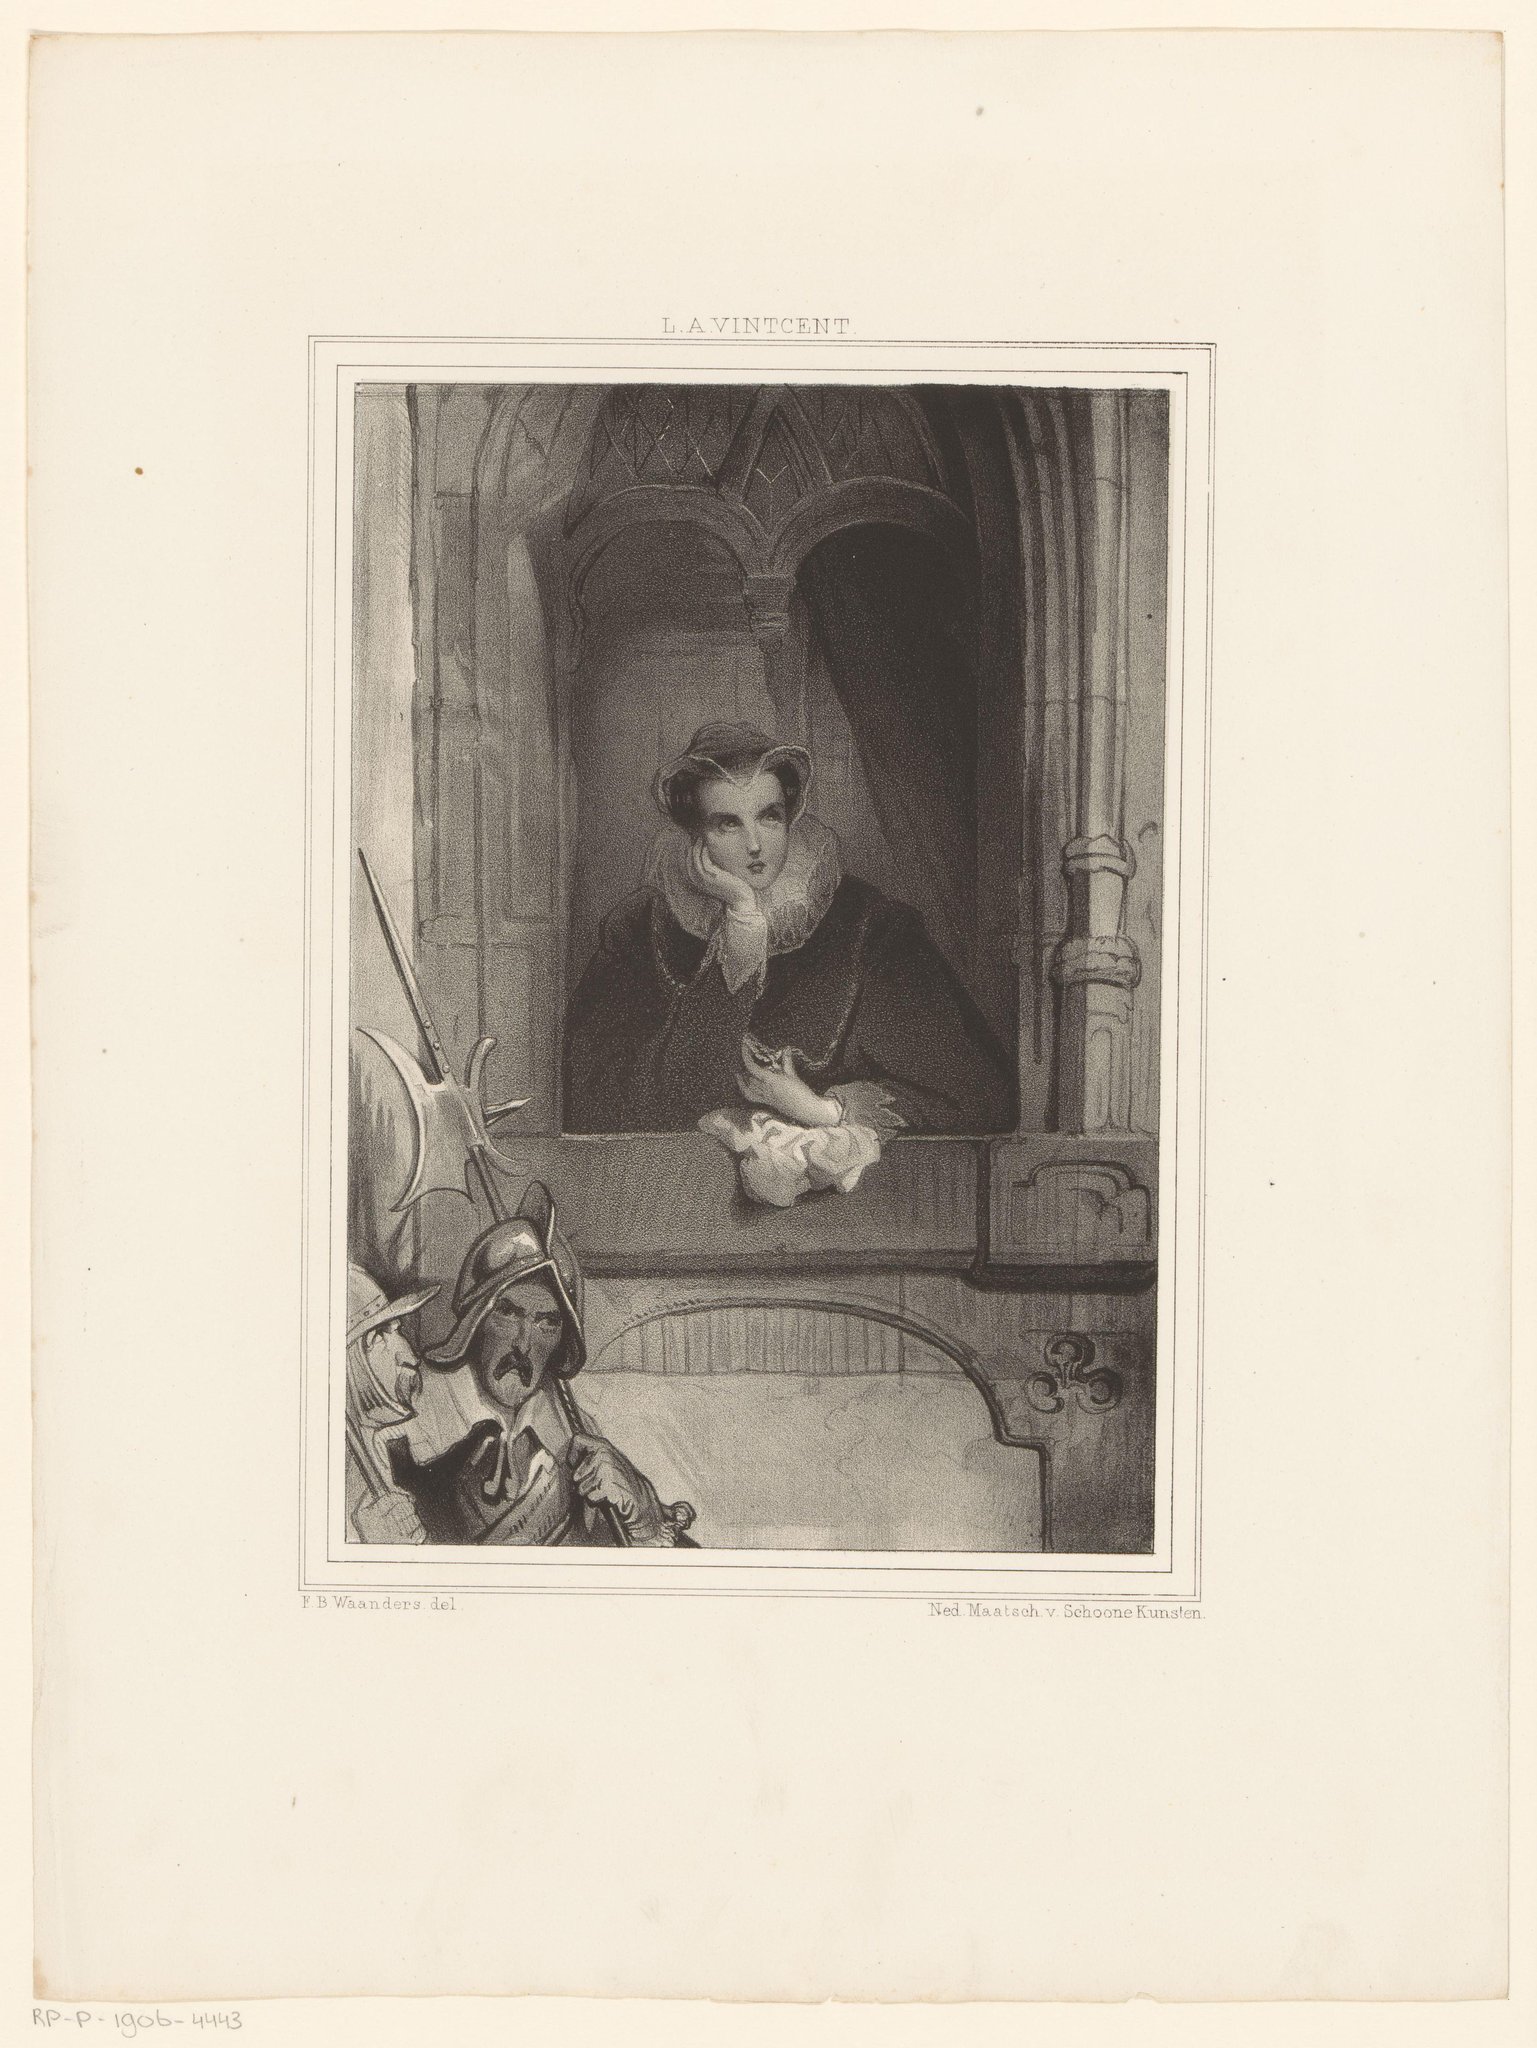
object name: print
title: Maria I Stuart in de gevangenis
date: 1842-1843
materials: paper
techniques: lithograph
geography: the hague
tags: prisoner in cell or locked place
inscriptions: collector's mark: Lugt 2228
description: Maria Stuart, koningin van Schotland, leunt vanuit haar cel uit het raam. Links lopen twee wachters.